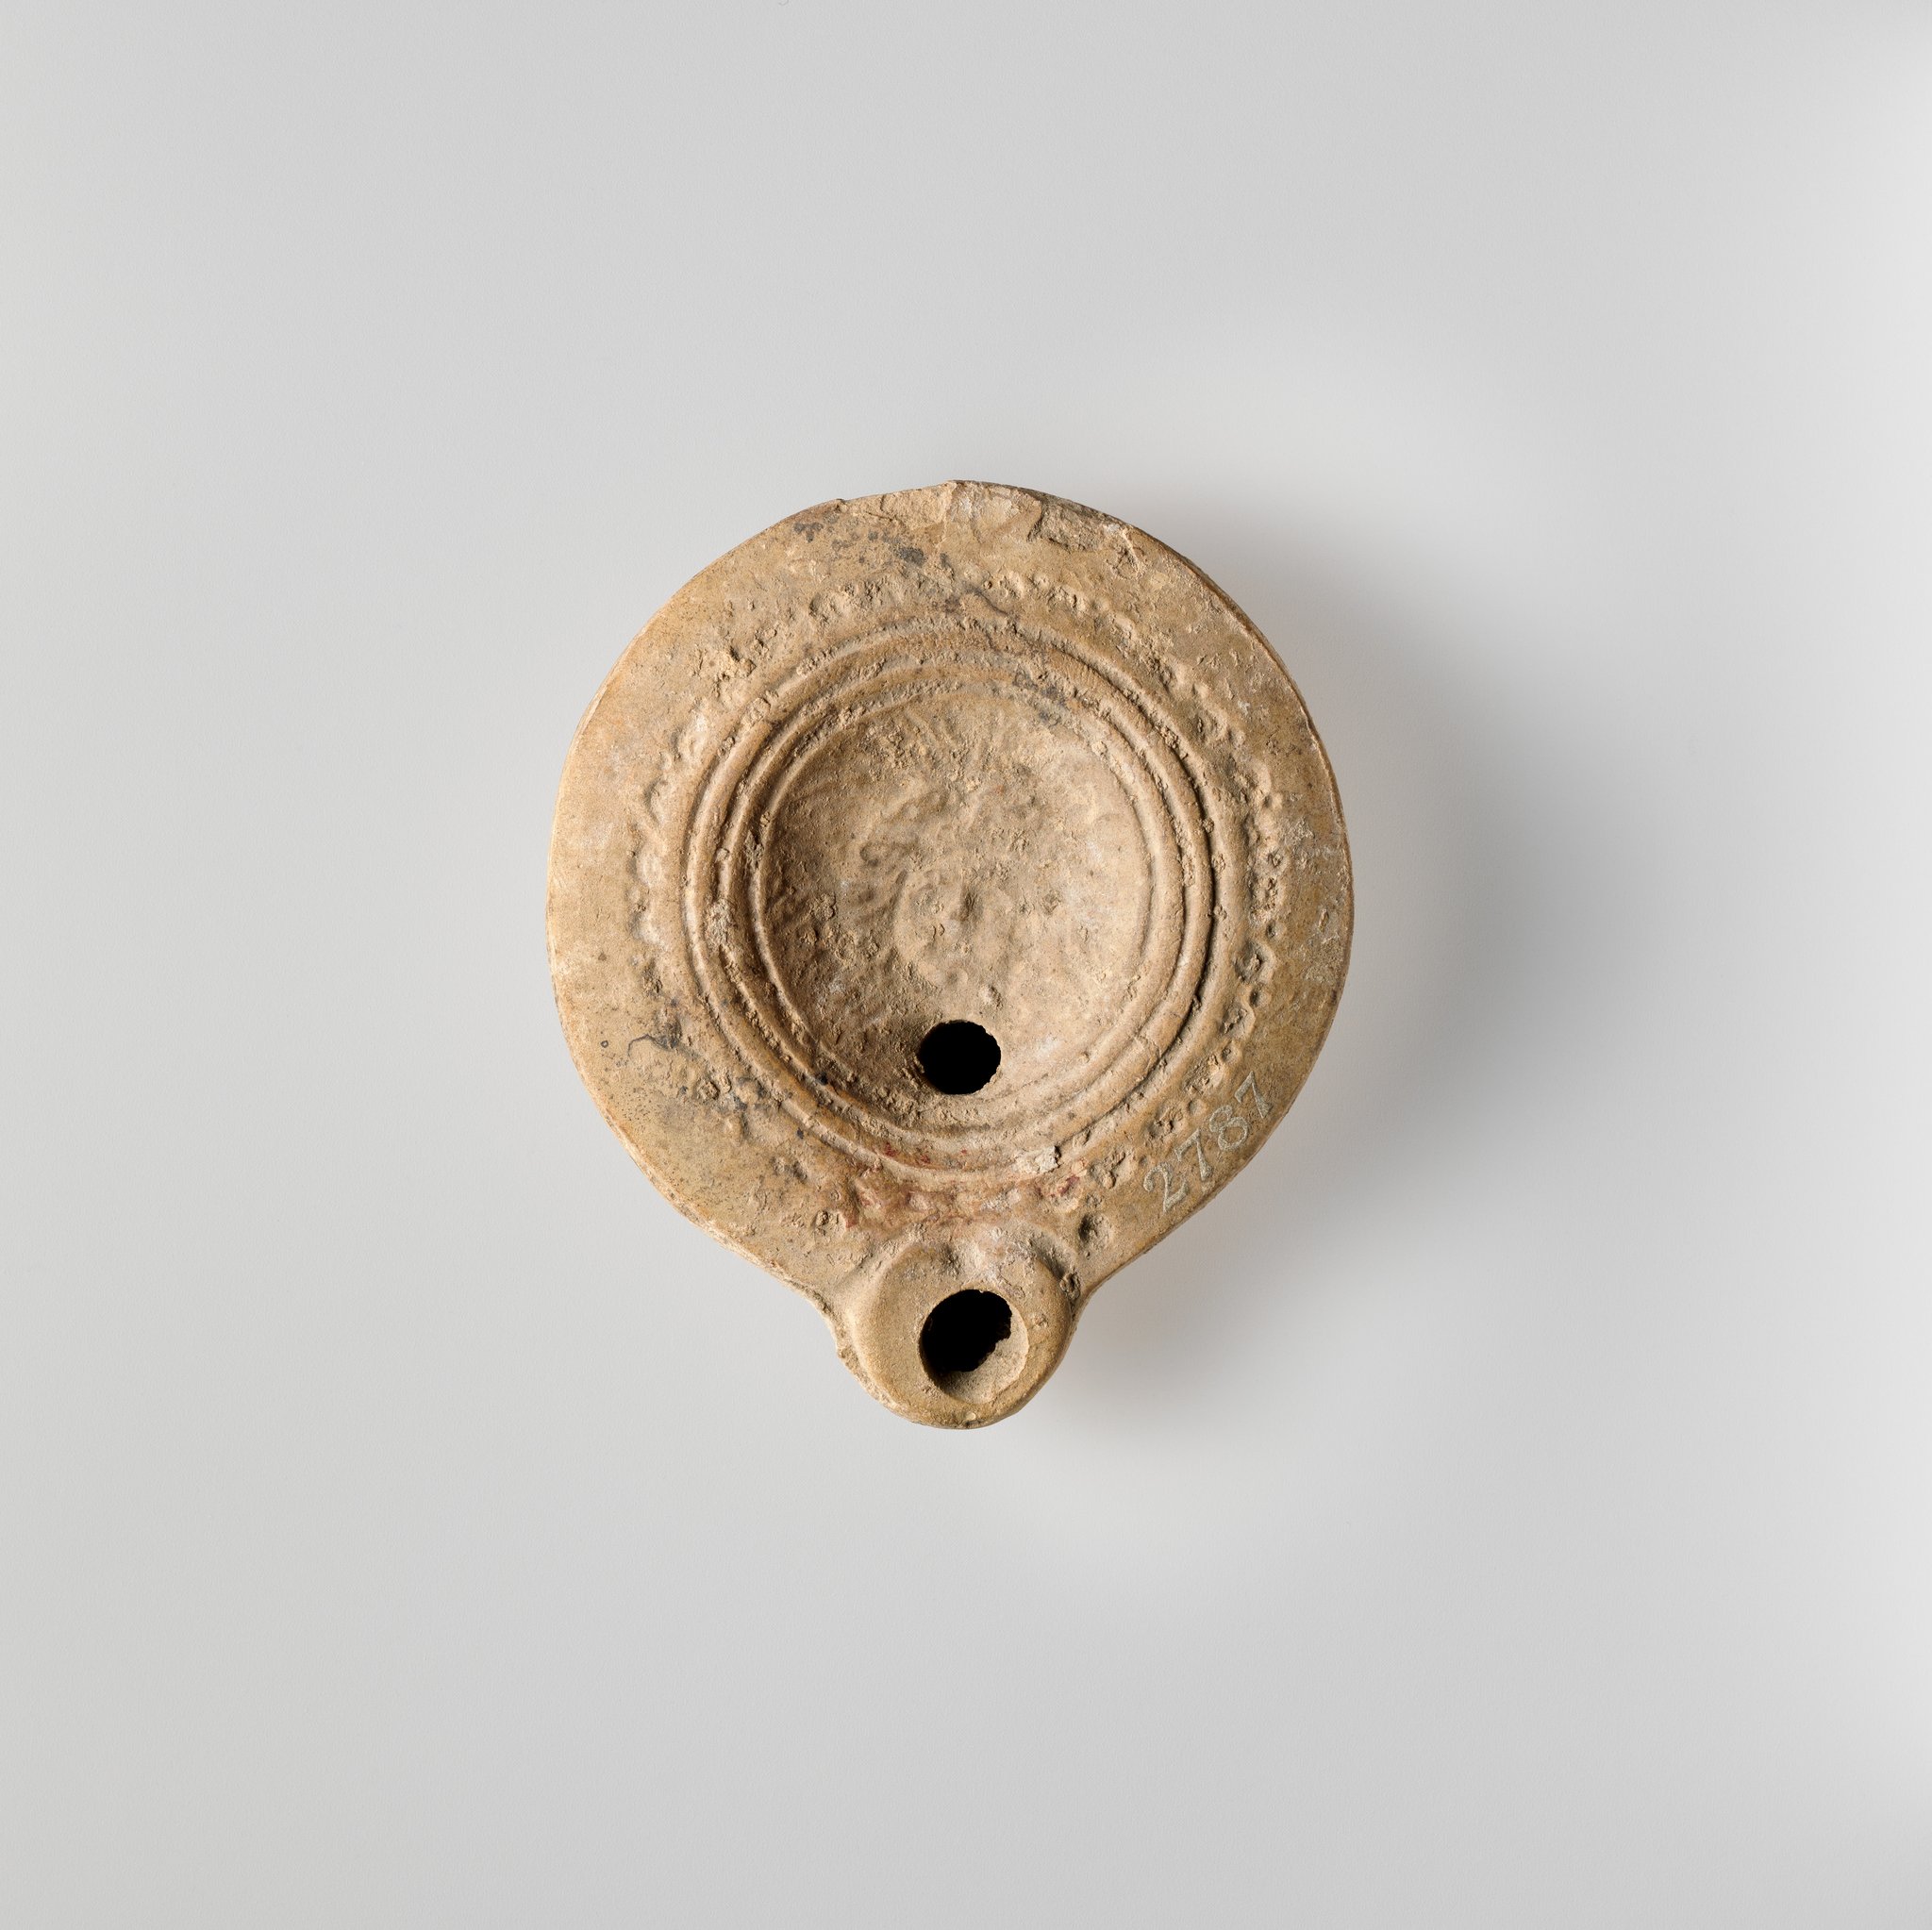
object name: lamp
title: Terracotta oil lamp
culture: roman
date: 101-200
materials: terracotta